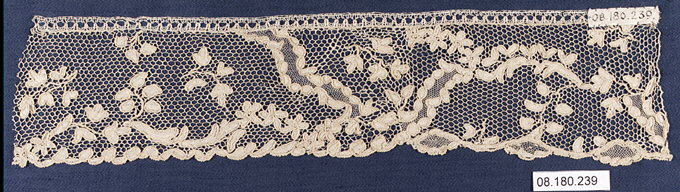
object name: fragment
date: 1701-1800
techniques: lace